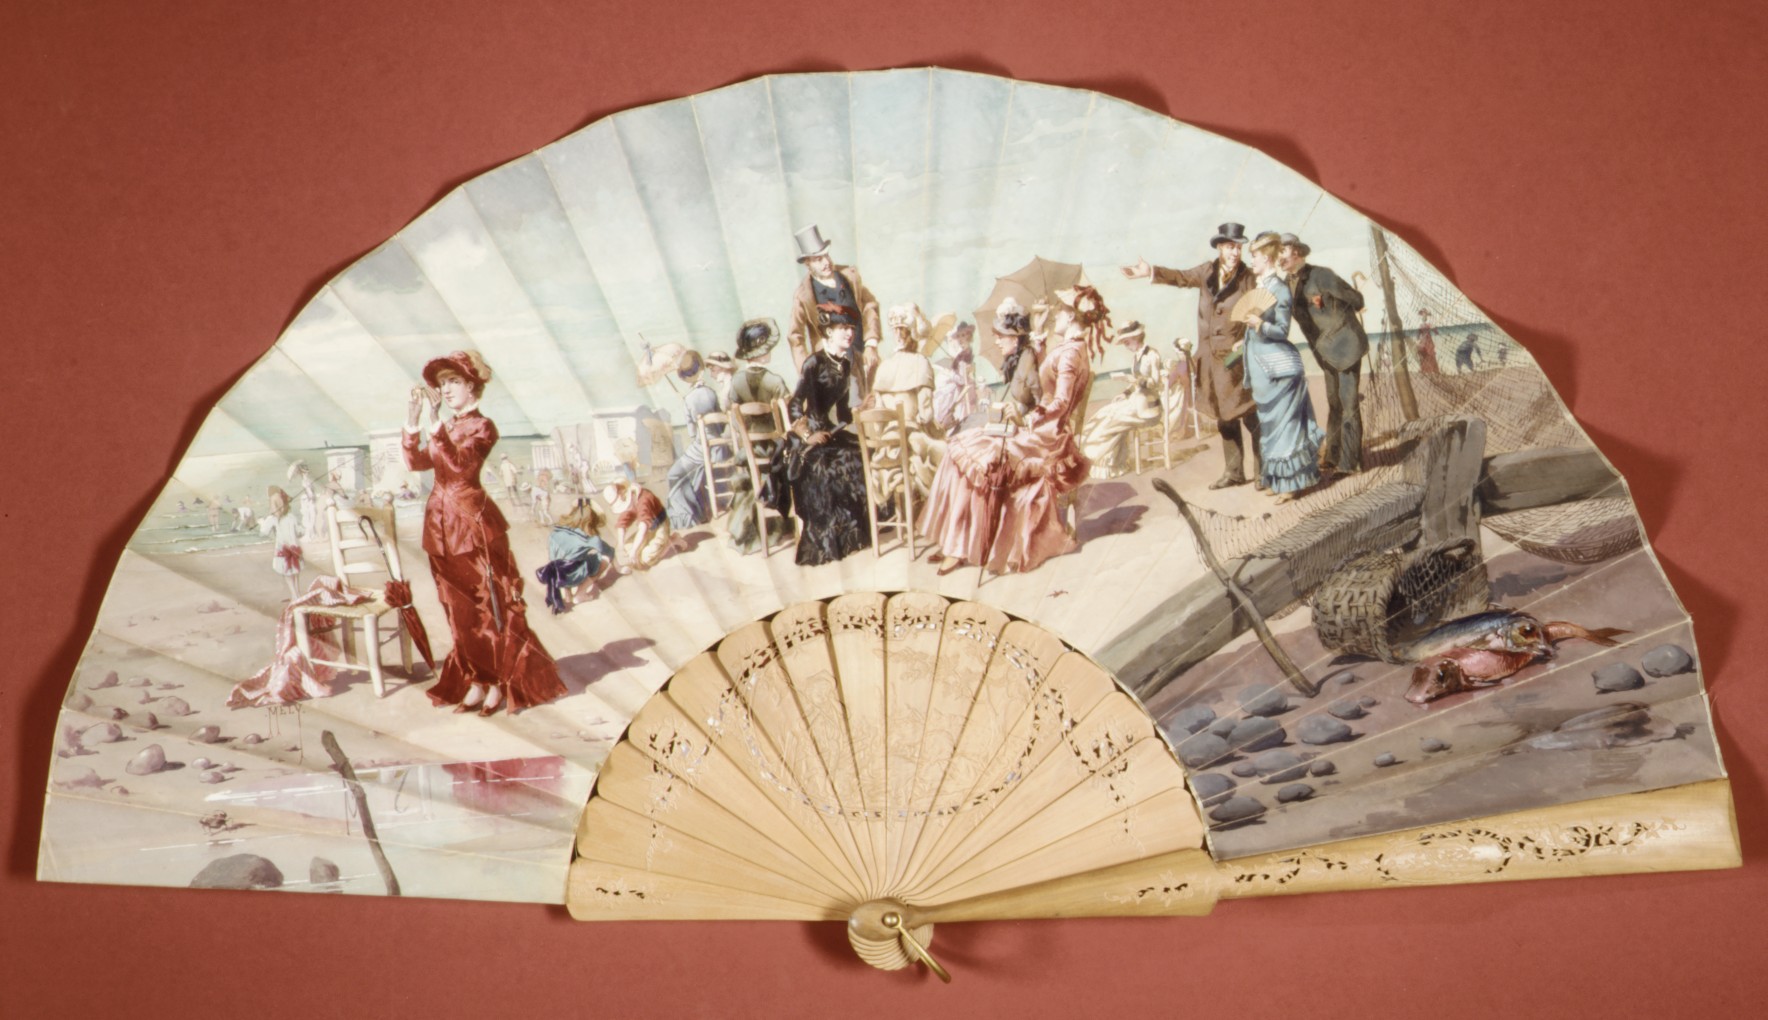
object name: fan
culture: american or european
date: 1880-1889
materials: paint, silk, wood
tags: men,women,fish,beaches